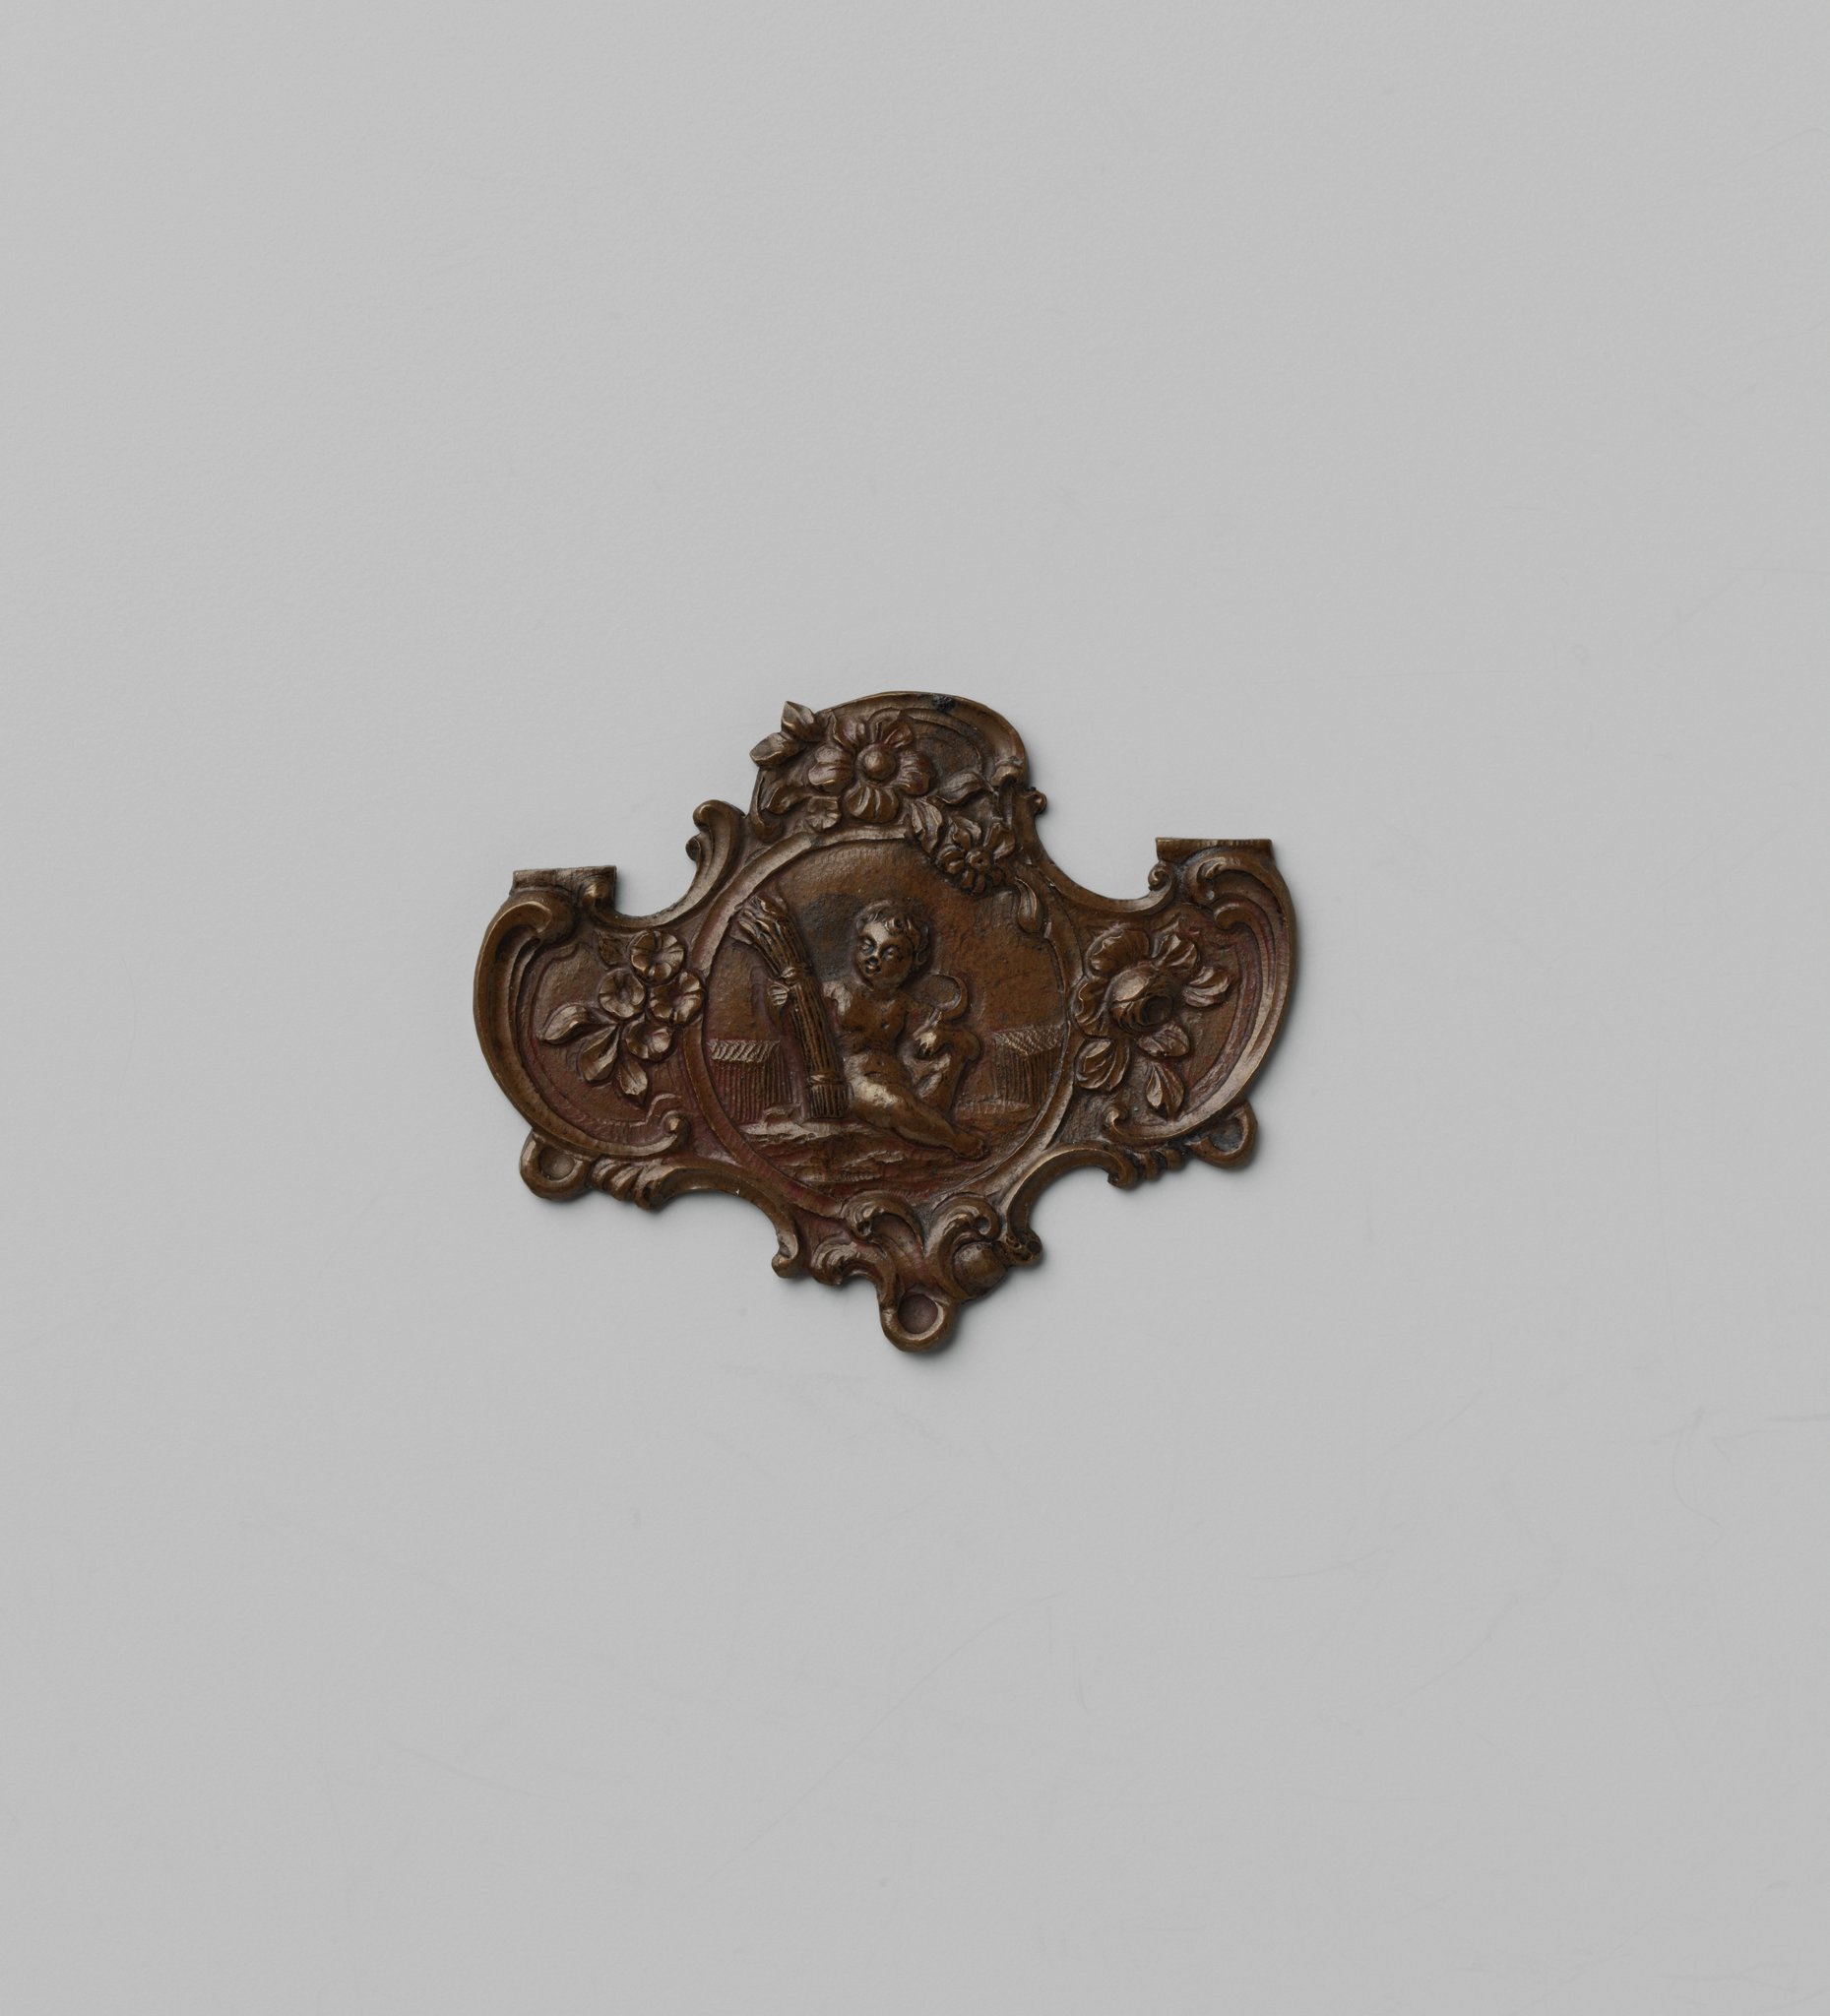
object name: model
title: Model voor een versieringselement van een chatelaine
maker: Anonymous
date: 1750-1775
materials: copper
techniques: repoussé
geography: amsterdam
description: Het uit plaat gedreven model voor een gietvorm is voorzien van een door rococo-ornament en bloemen omgevenmedaillon met een putto met korenschoof en een sikkel. Onderaan langs de randen drie ogenter bevestiging van schakels.